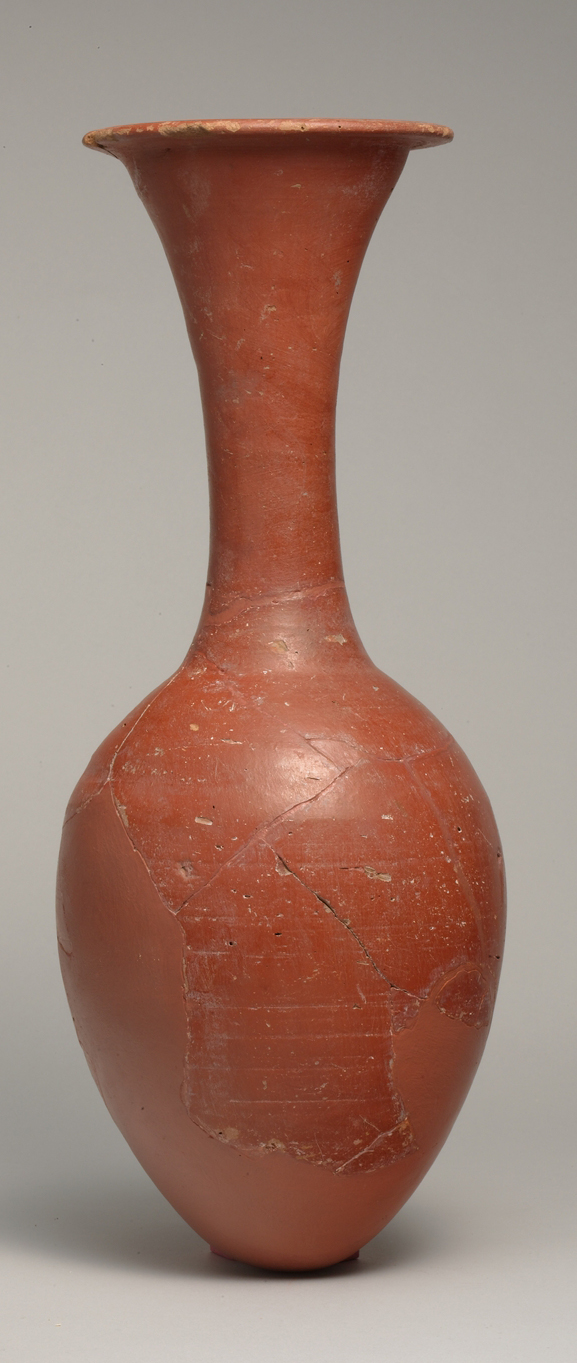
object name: bottle, long necked, wine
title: Water Bottle from Tutankhamun's Embalming Cache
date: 1336-1327 BCE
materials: mineral, pottery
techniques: burnishing, wash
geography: egypt